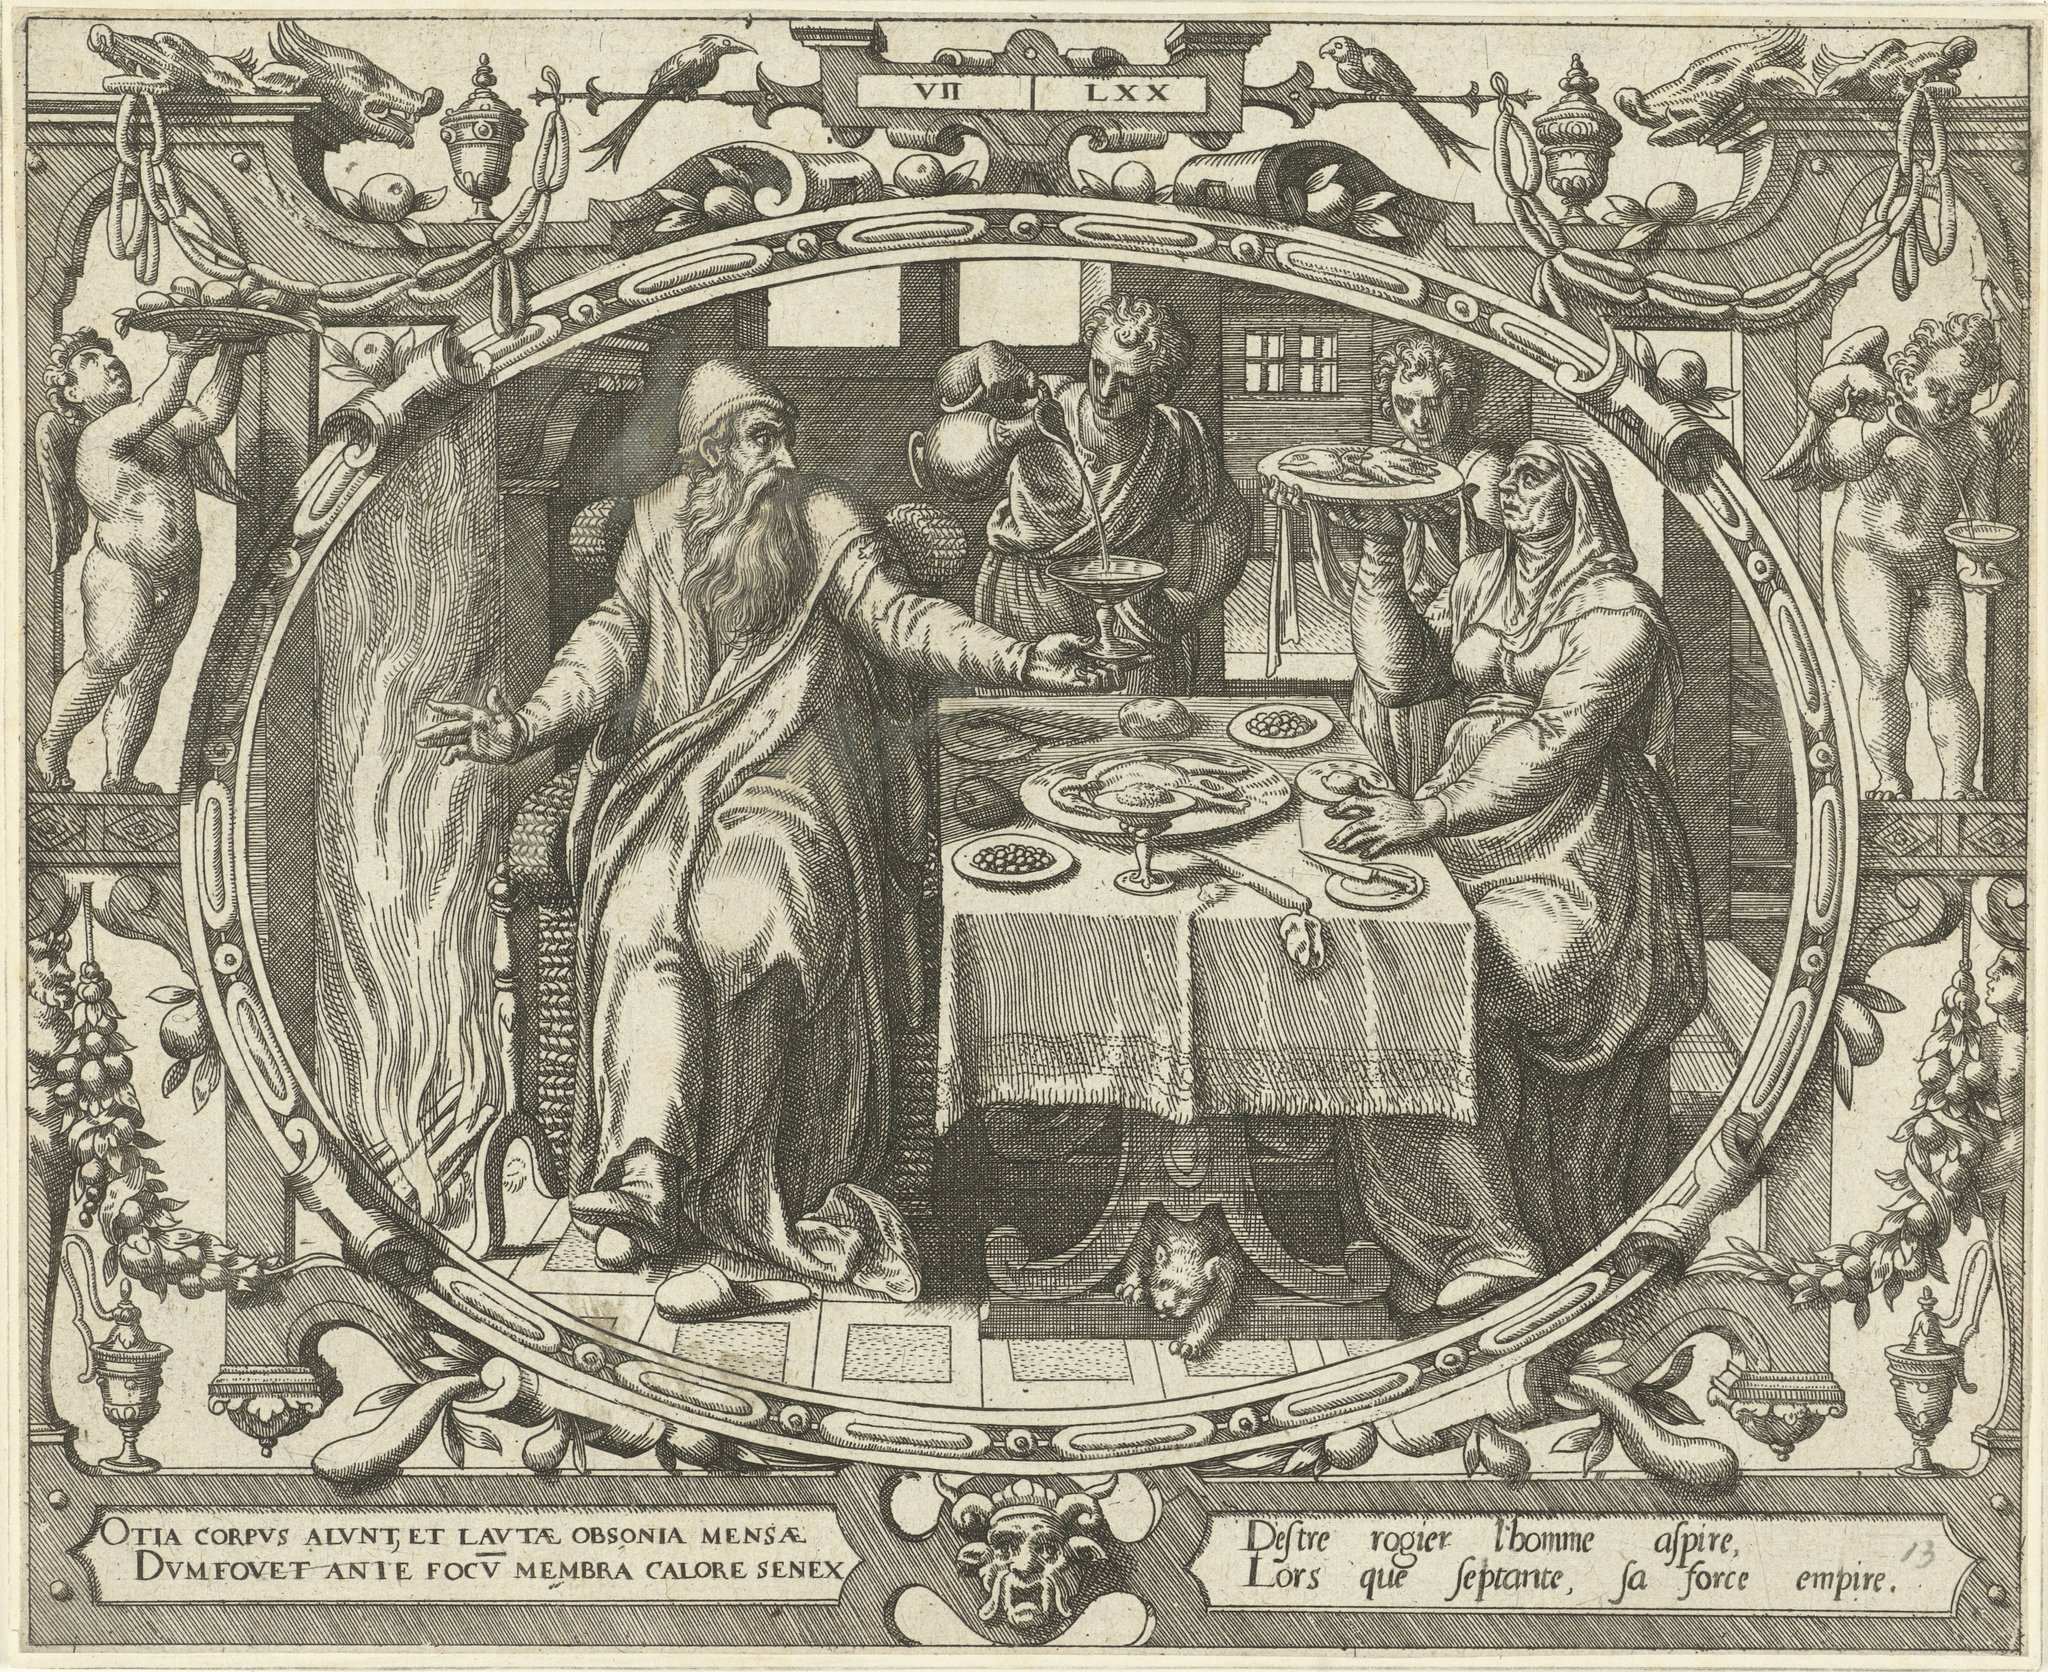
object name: print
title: Tien leeftijden van de mens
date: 1569-1575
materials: paper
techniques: engraving, etching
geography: antwerp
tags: old man, old woman, celebration meal, feast, banquet, hearth and stove, house personnel, servants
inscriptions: collector's mark: Lugt 2228, collector's mark: Lugt 698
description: In een ovaal kader versierd met ornamenten een voorstelling van een oude man samen met zijn vrouw aan tafel bij het haardvuur. Bedienden schenken hen voedsel en drank. De prent heeft een Latijns en Frans onderschrift.